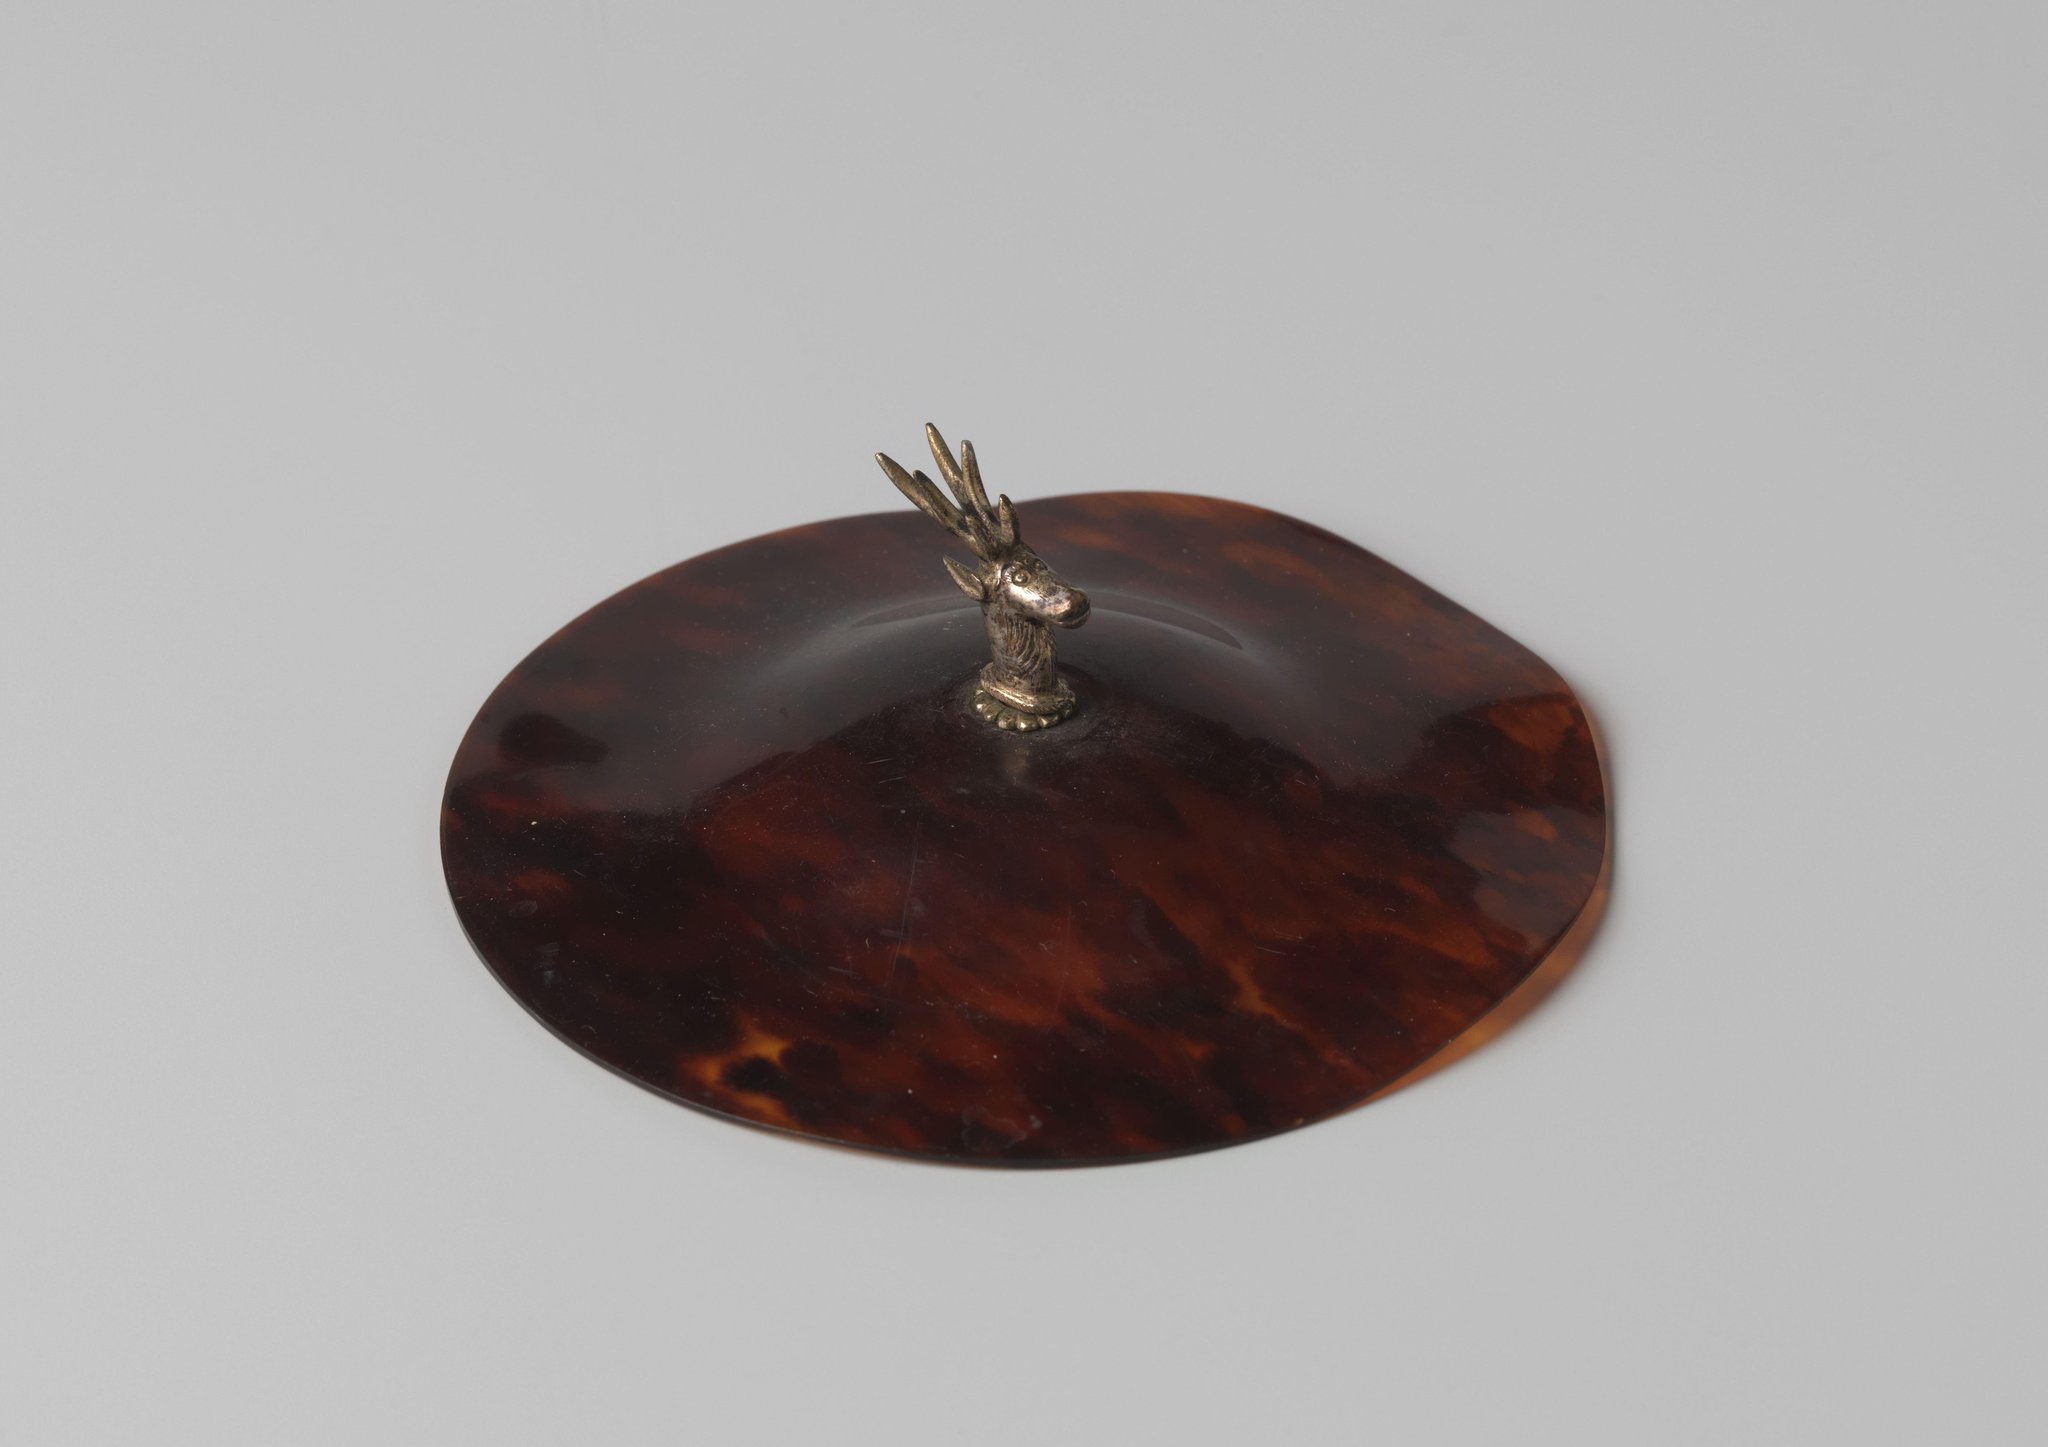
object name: lid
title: Deksel van schildpad met hertekop van zilver (serie van 28 stuks A t/m BB)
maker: Anonymous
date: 1700-1799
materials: silver, shell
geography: indonesia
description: Schildpad-deksel (28 stuks: A t/m BB) met hertekop van zilver als knop.